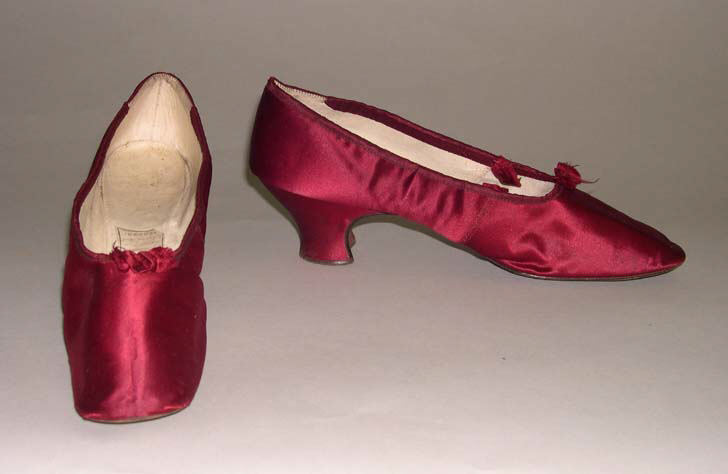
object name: evening shoe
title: Evening shoes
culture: british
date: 1850-1859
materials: leather, silk